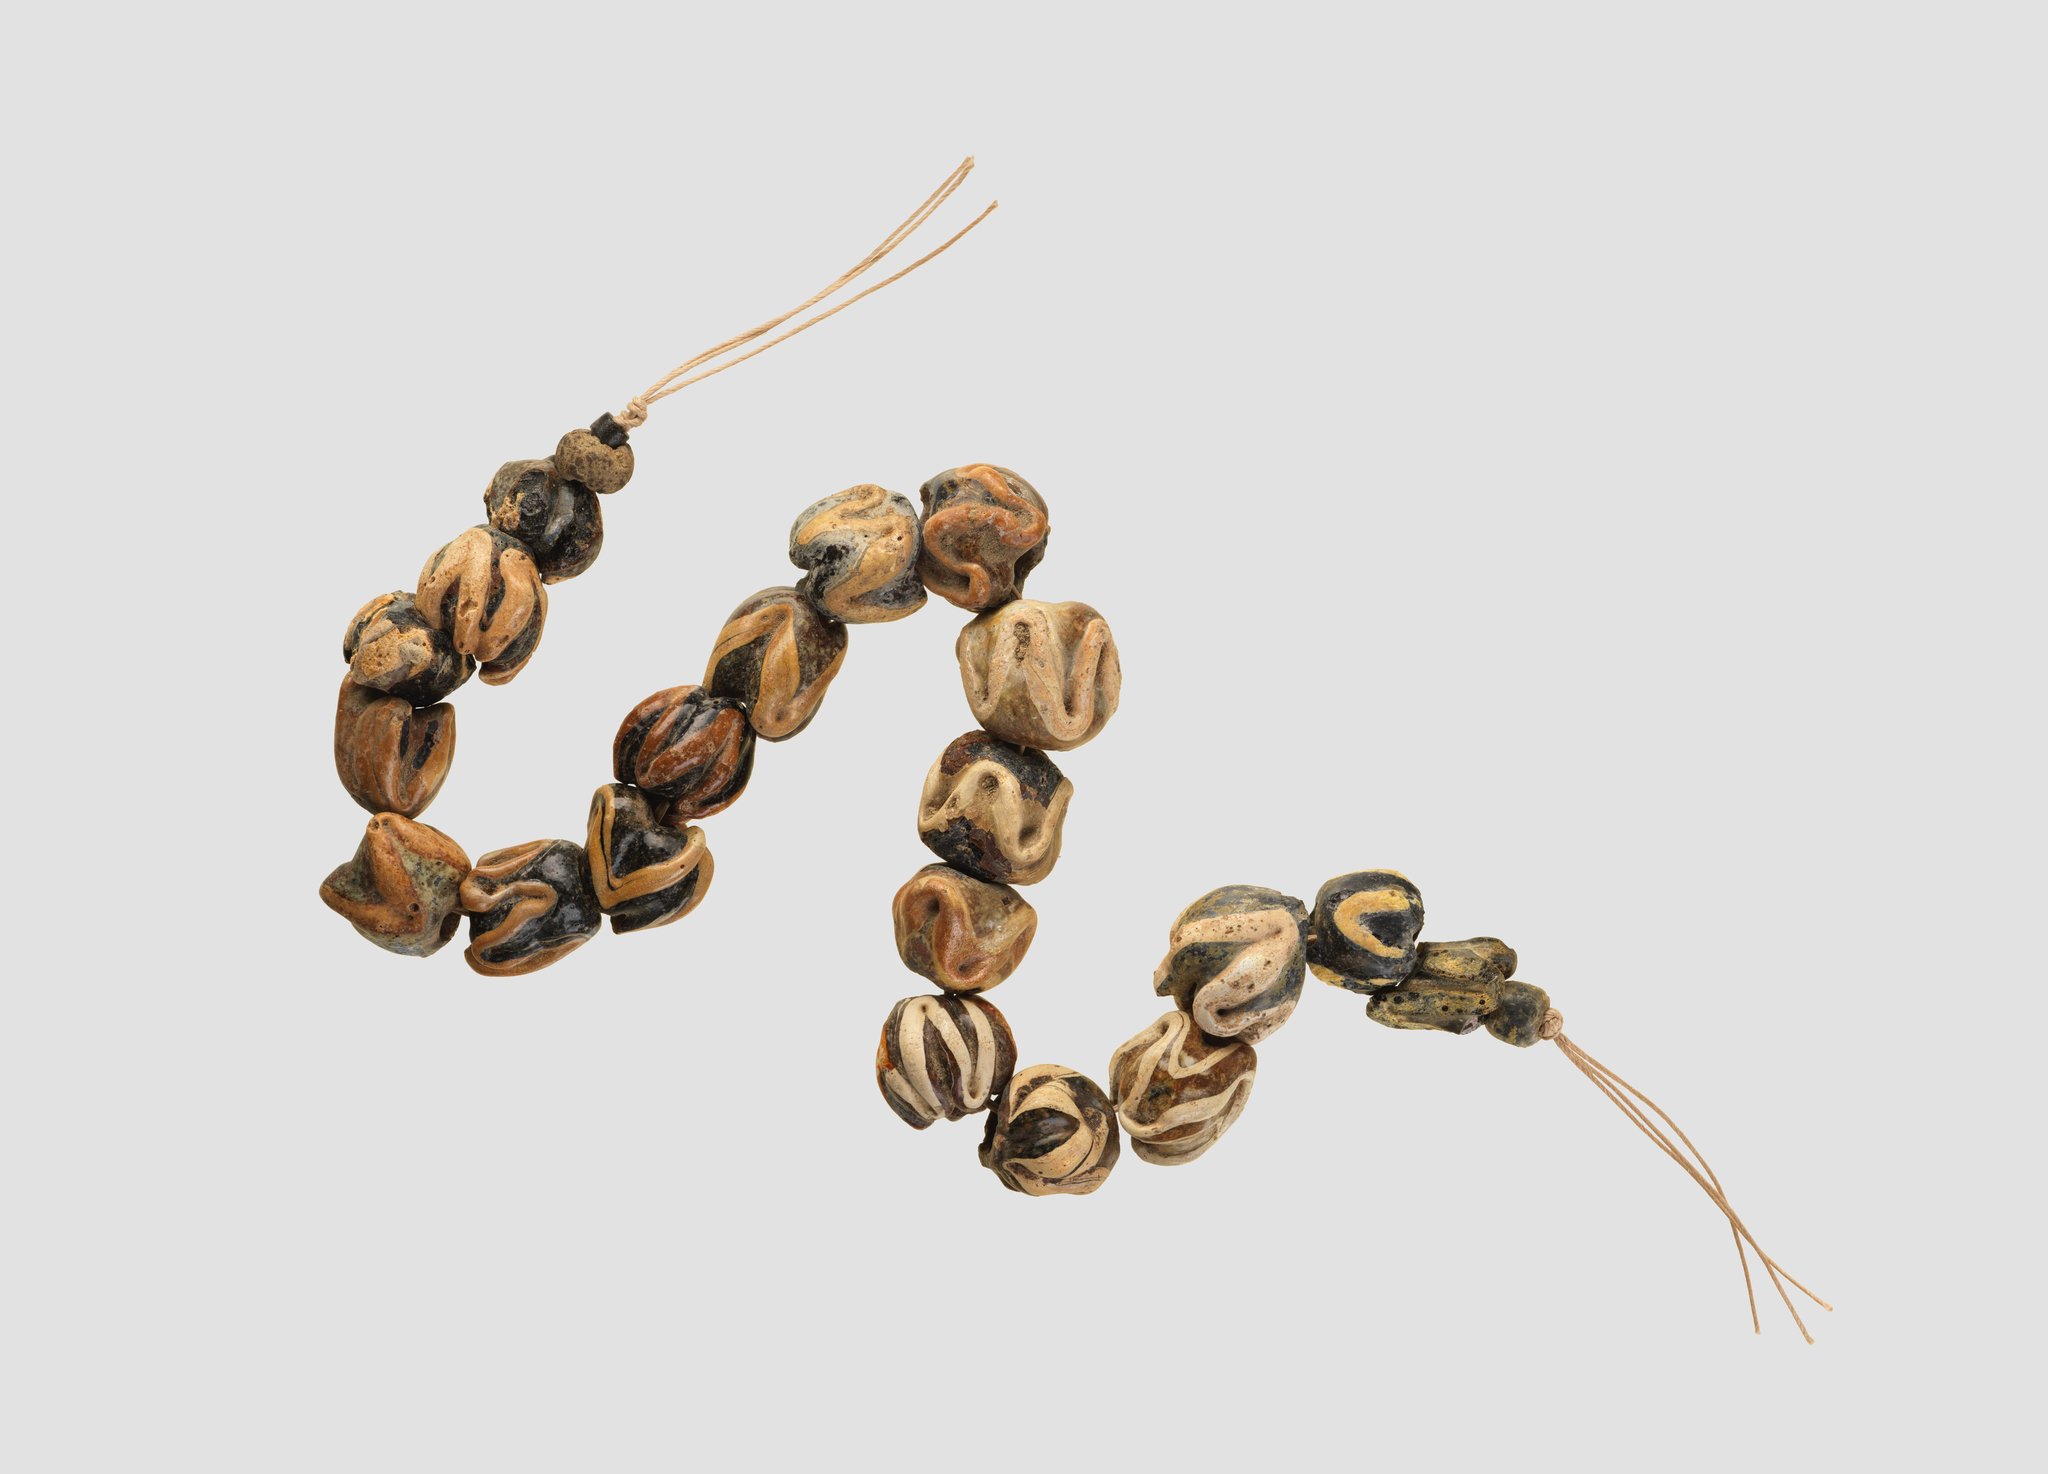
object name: bead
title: Beads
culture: iranian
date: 900-801 BCE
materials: glass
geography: iran